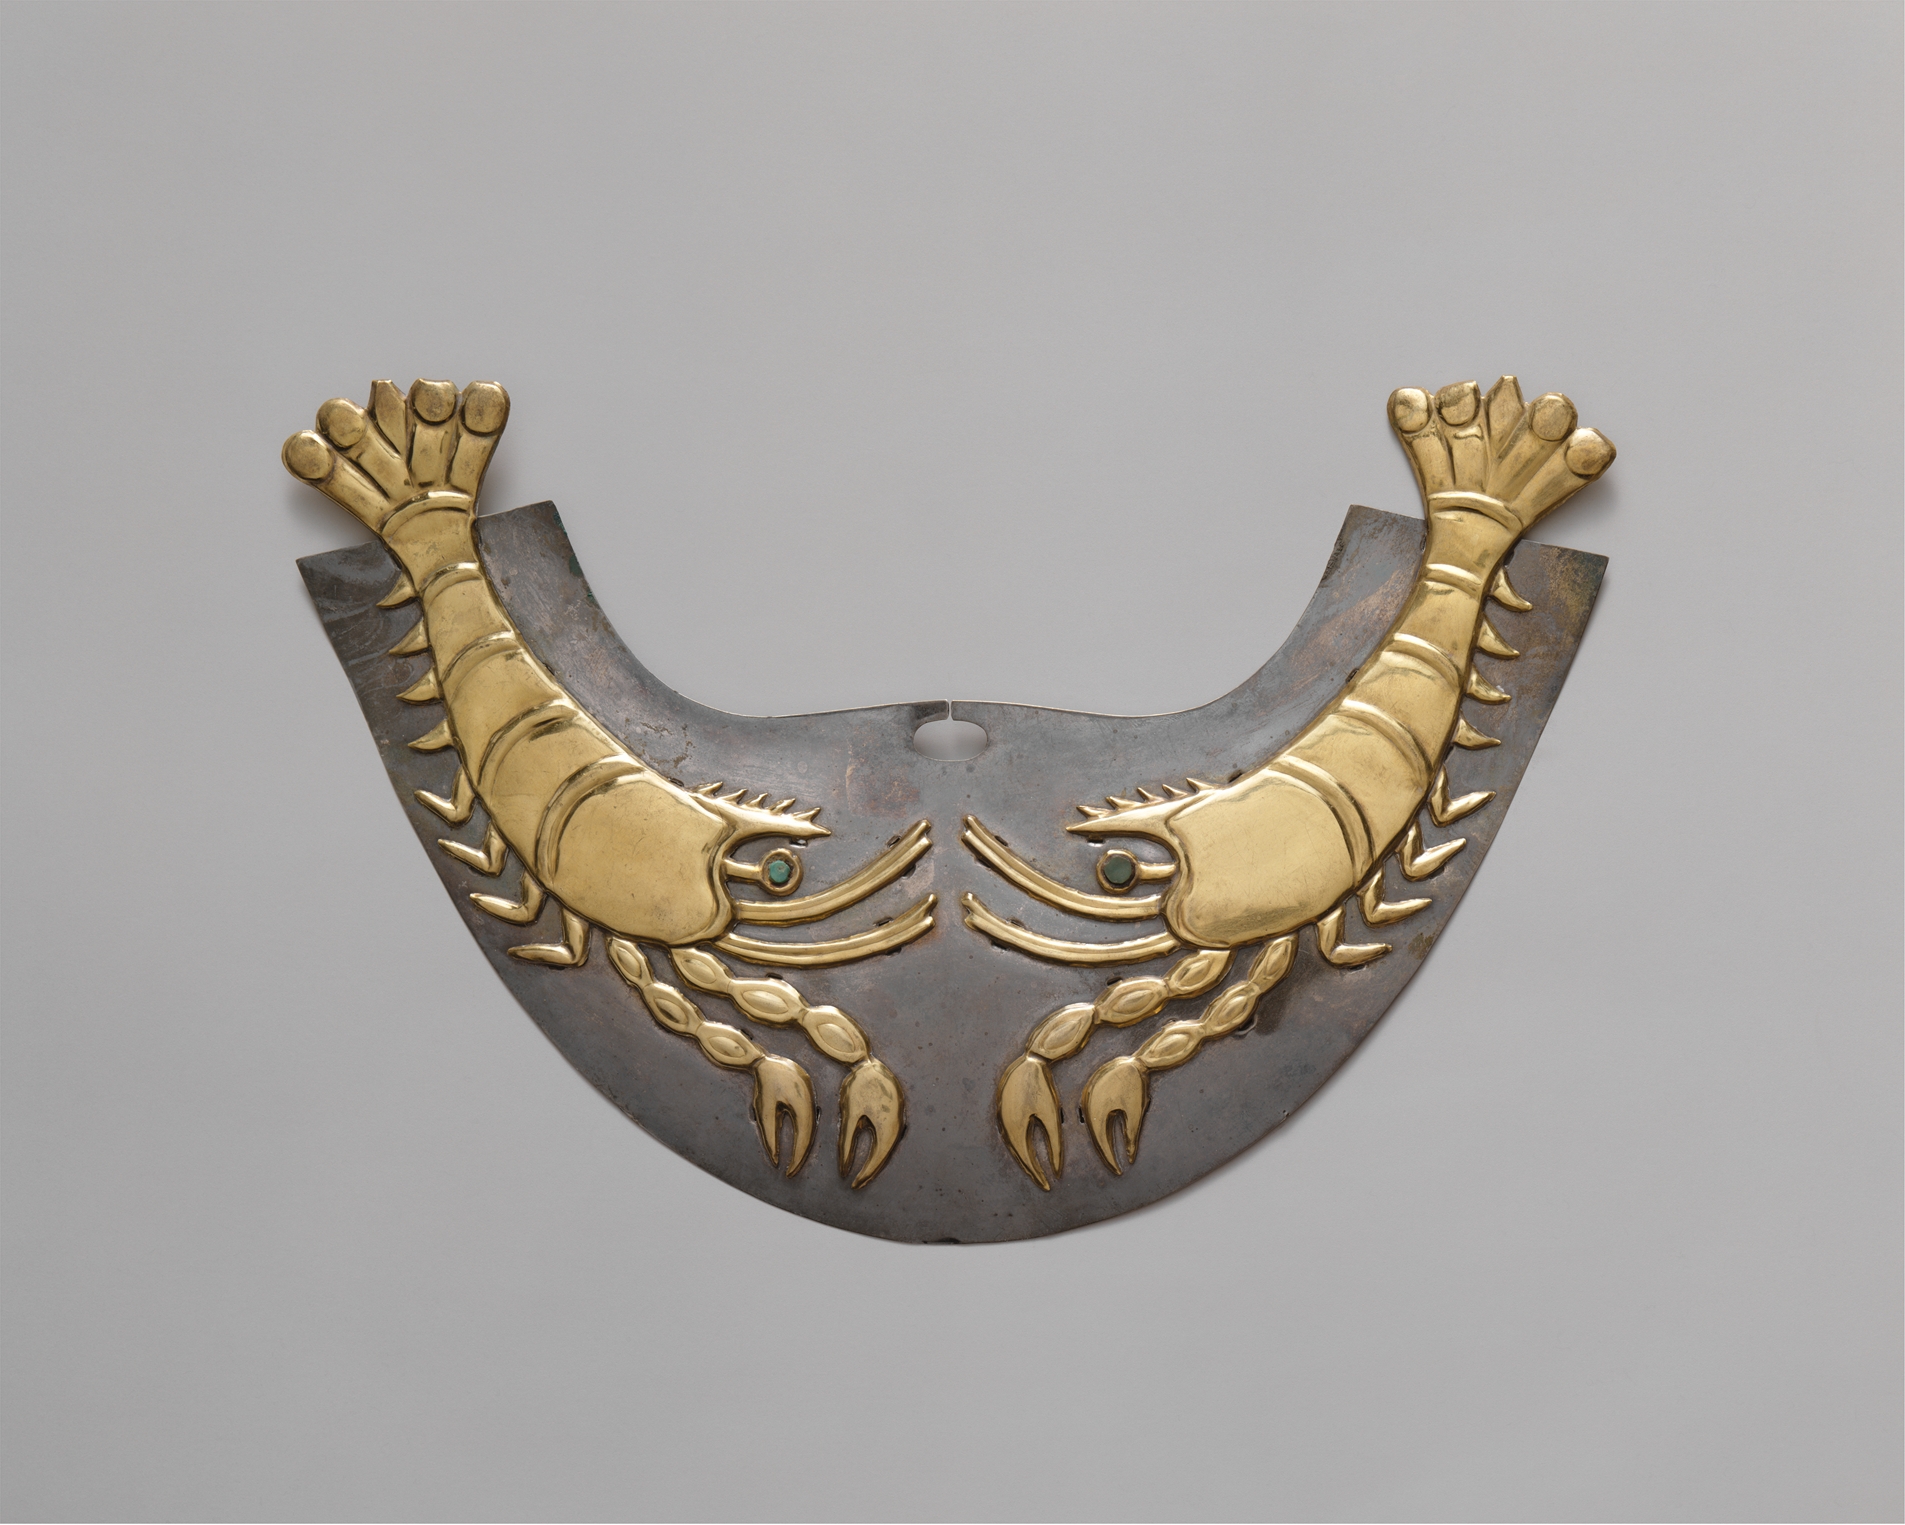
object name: nose ornament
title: Nose Ornament with Shrimp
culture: moche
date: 500-800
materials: gold, silver, stone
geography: peru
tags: animals